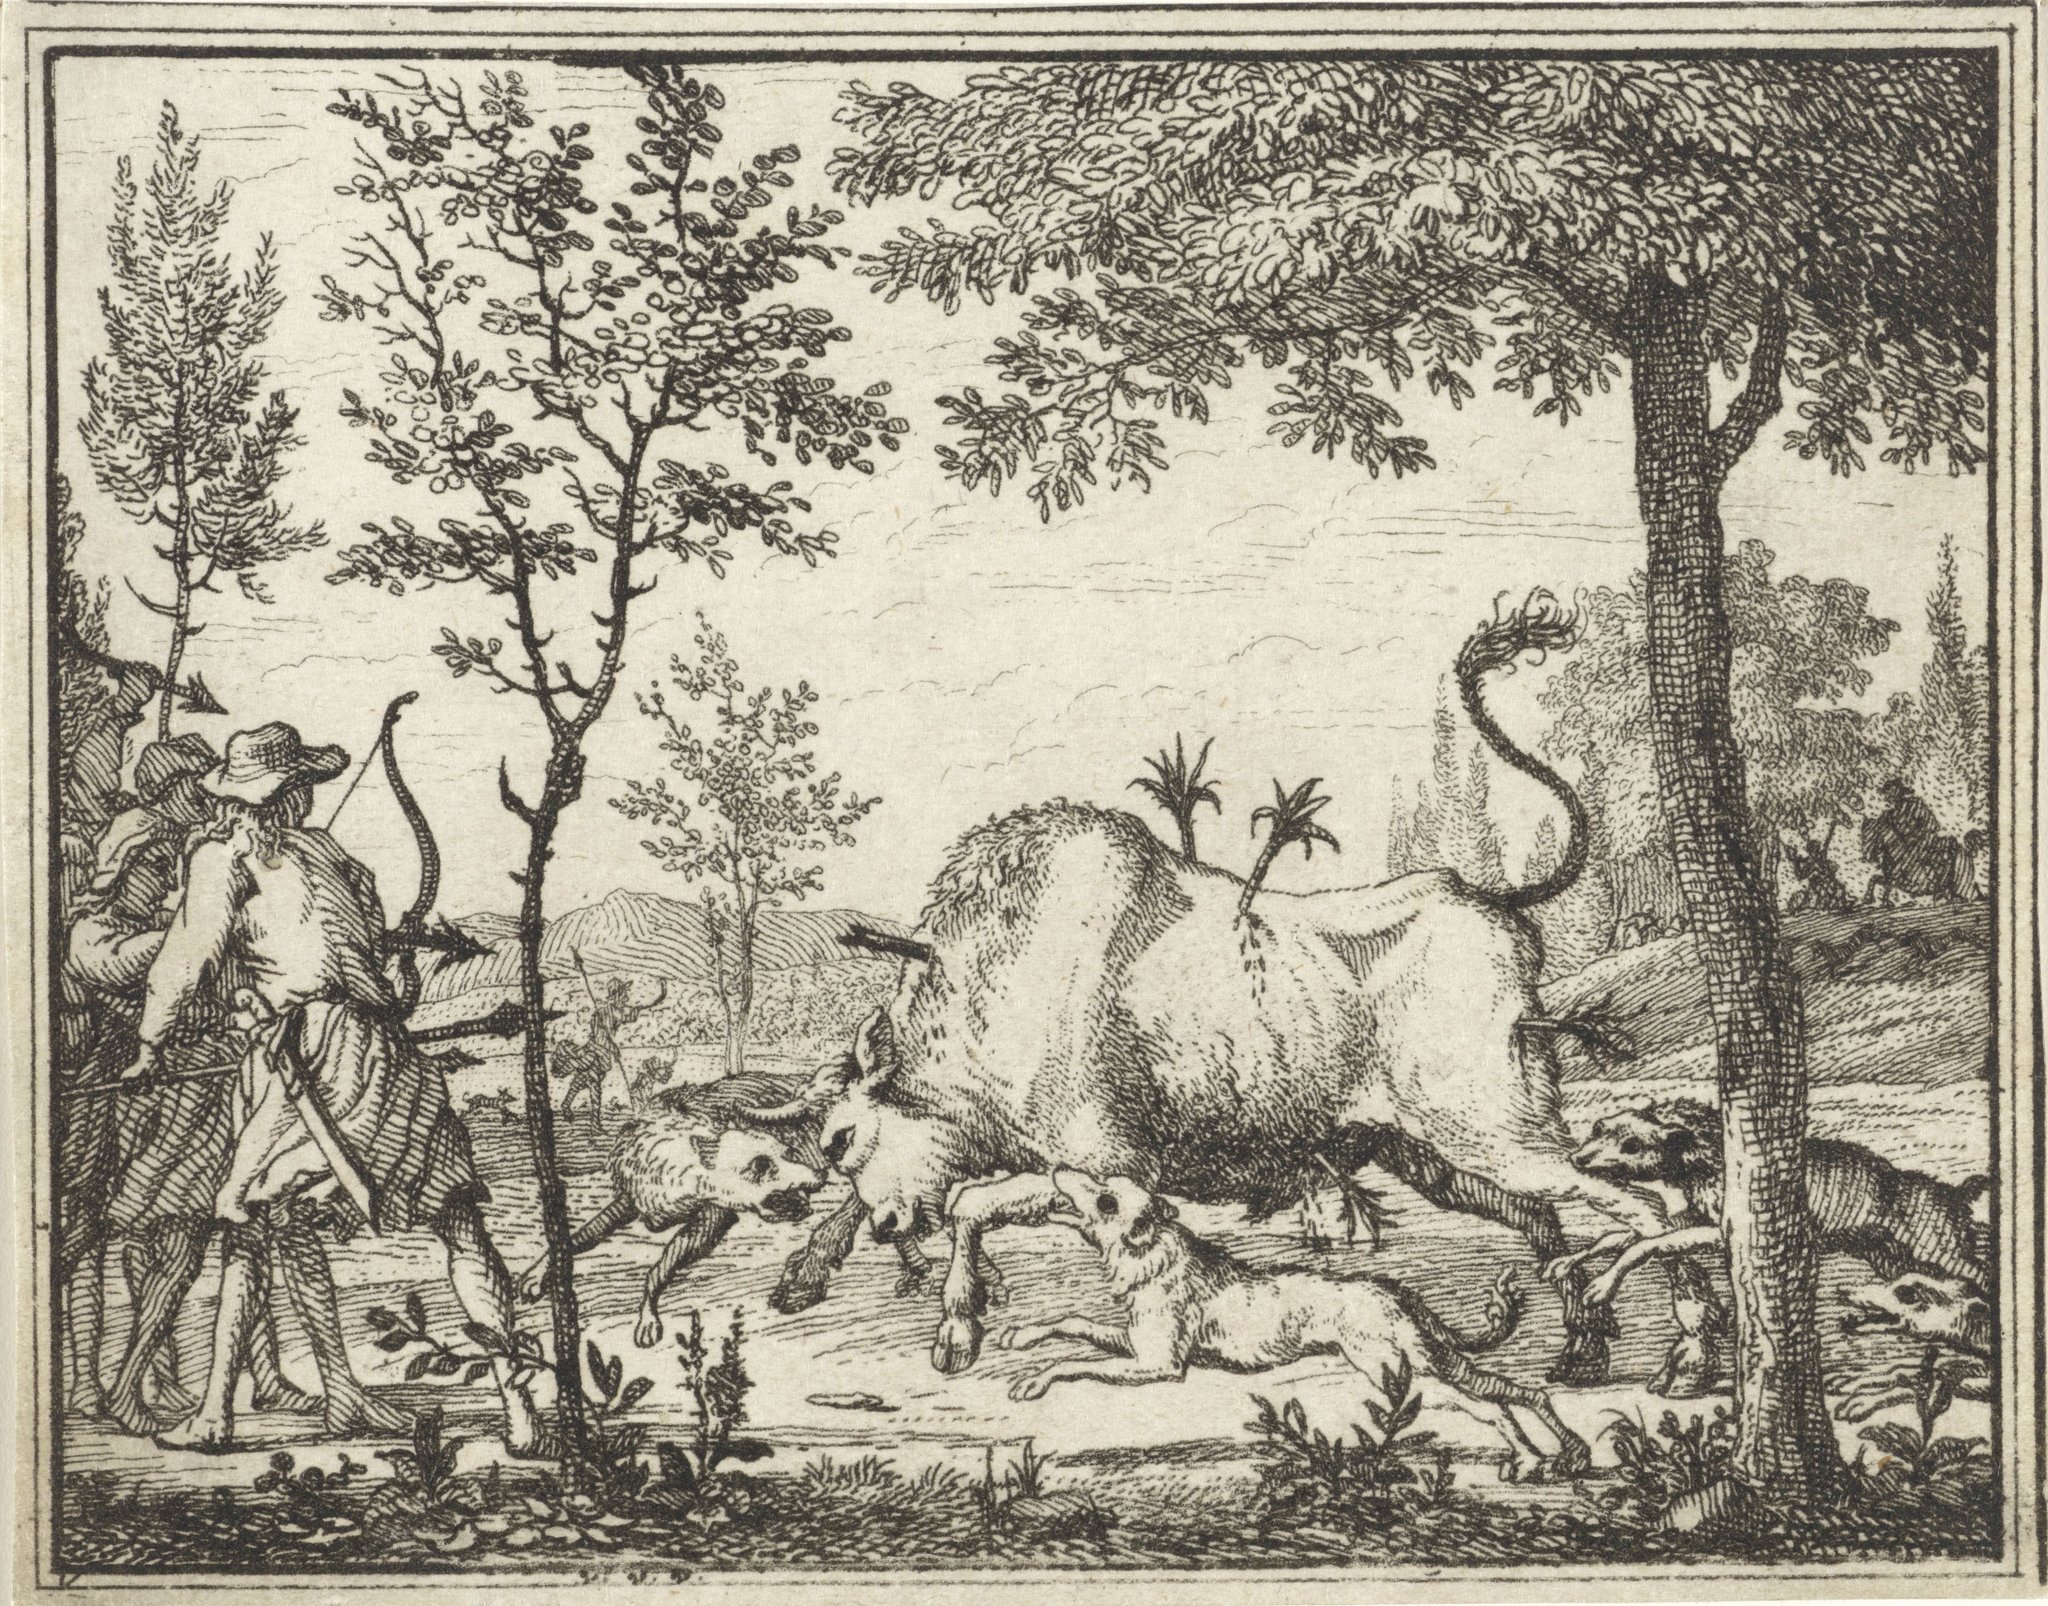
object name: print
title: Jagers met honden schieten pijlen op een stier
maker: vincent laurensz. van der vinne (ii)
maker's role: draughtsman, print maker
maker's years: 1686-1742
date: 1714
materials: paper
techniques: etching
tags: bull, hunting dogs, hunter, hunt ~ hoofed animals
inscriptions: collector's mark: Lugt 2228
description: In een landschap schieten jagers pijlen en speren op een stier. Vier honden blaffen naar de stier en bijten in zijn poten. Drie pijlen steken in zijn rug. Zinnebeeld op de pijn die men voelt bij de eerste zonden, maar hoe het verstand zwijgt naarmate er meerdere verkeerde daden elkaar opvolgen.